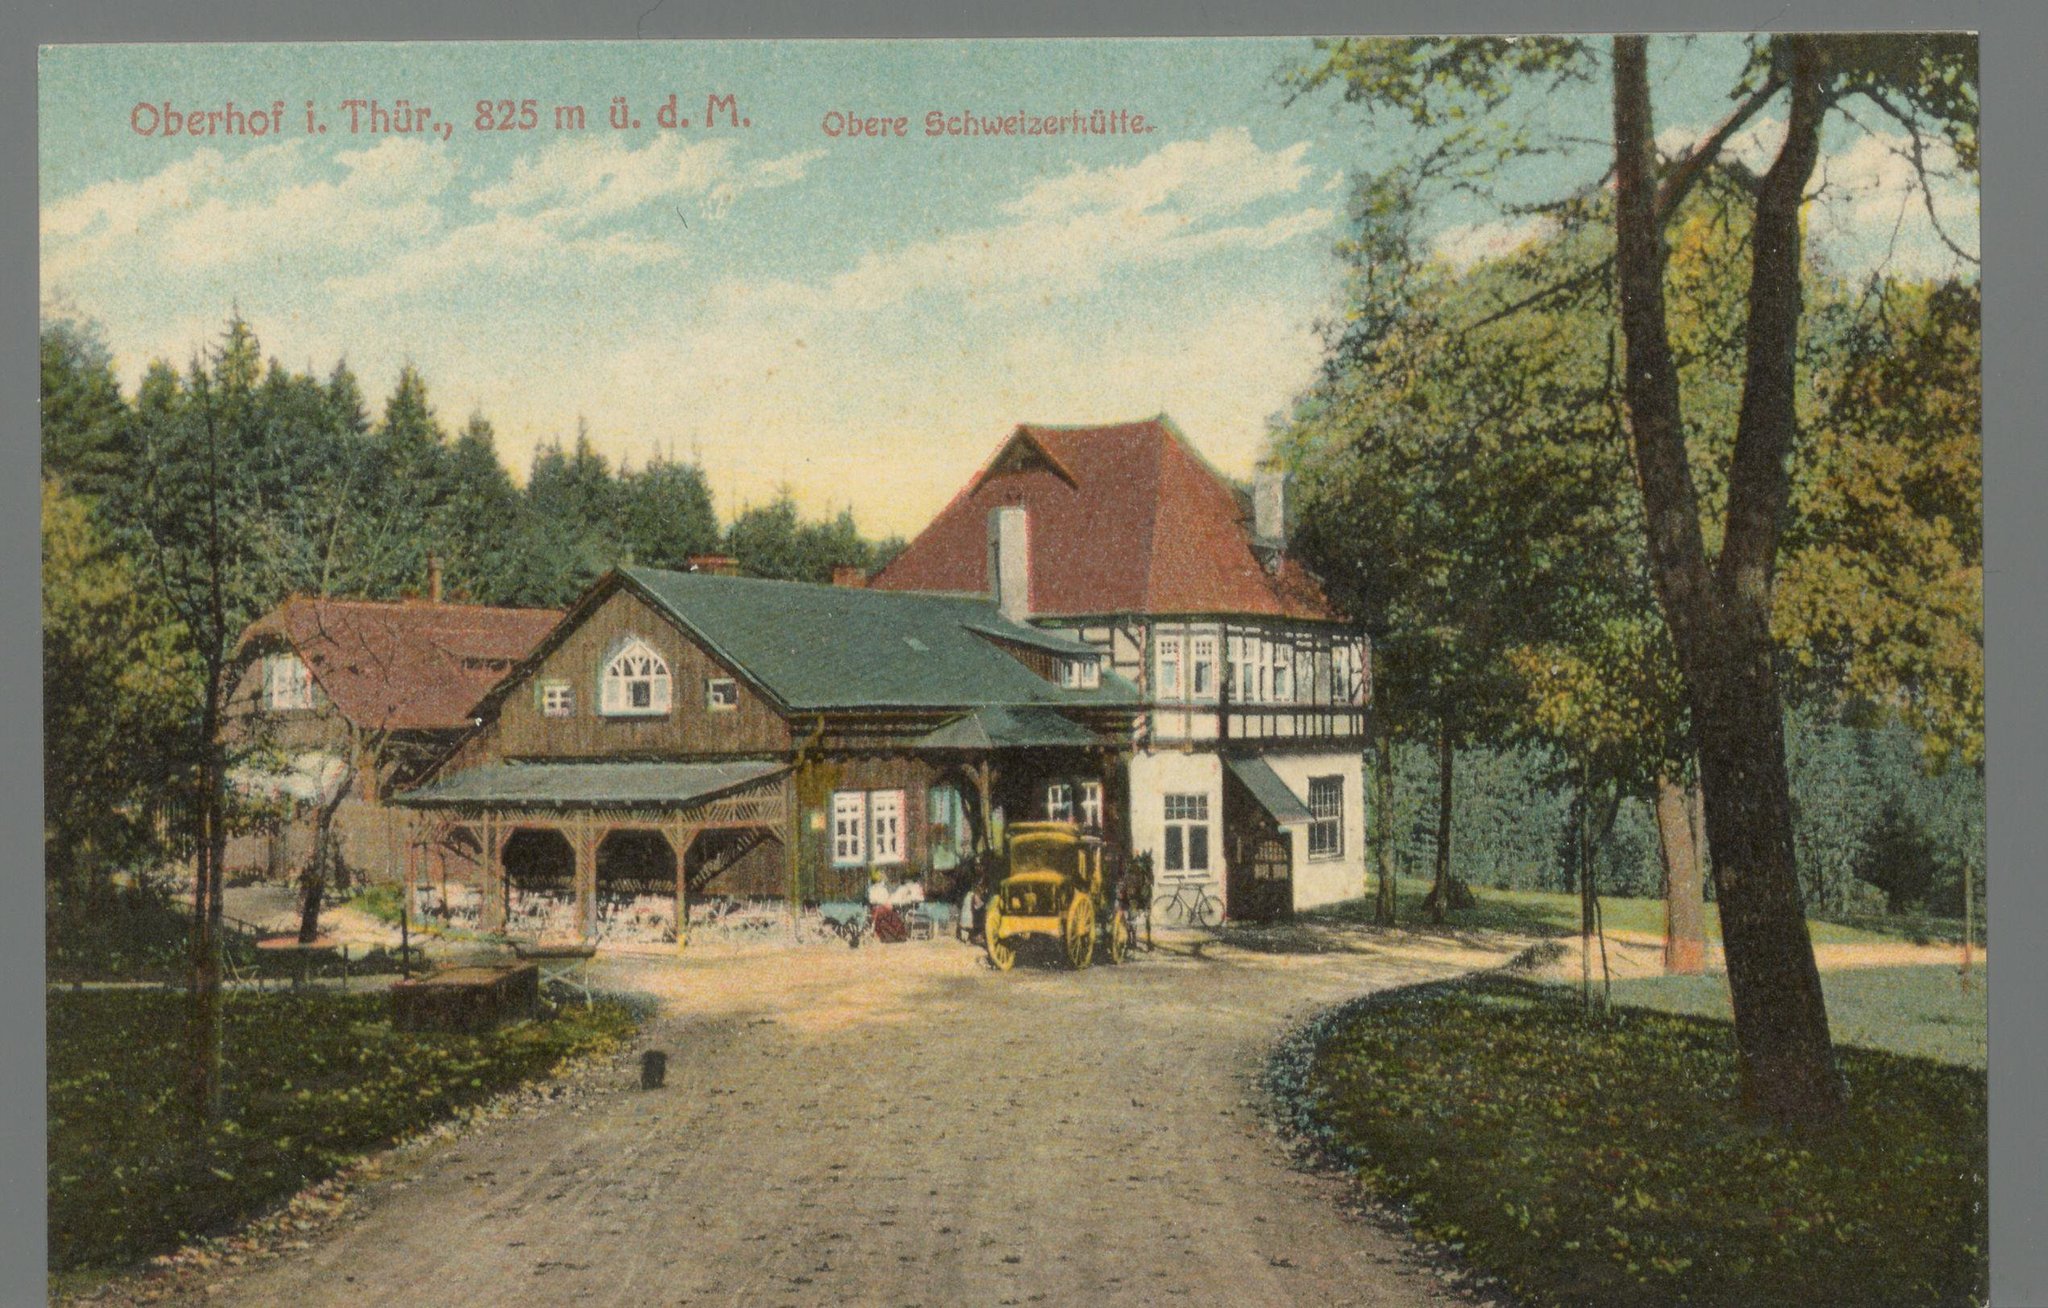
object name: ansichtkaart, prentbriefkaart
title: Oberhof i. Thür., 825 m ü. d. M. Obere Schweizerhütte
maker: Anonymous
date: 1905-1930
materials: cardboard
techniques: photograph, lithograph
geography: oberhof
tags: villa